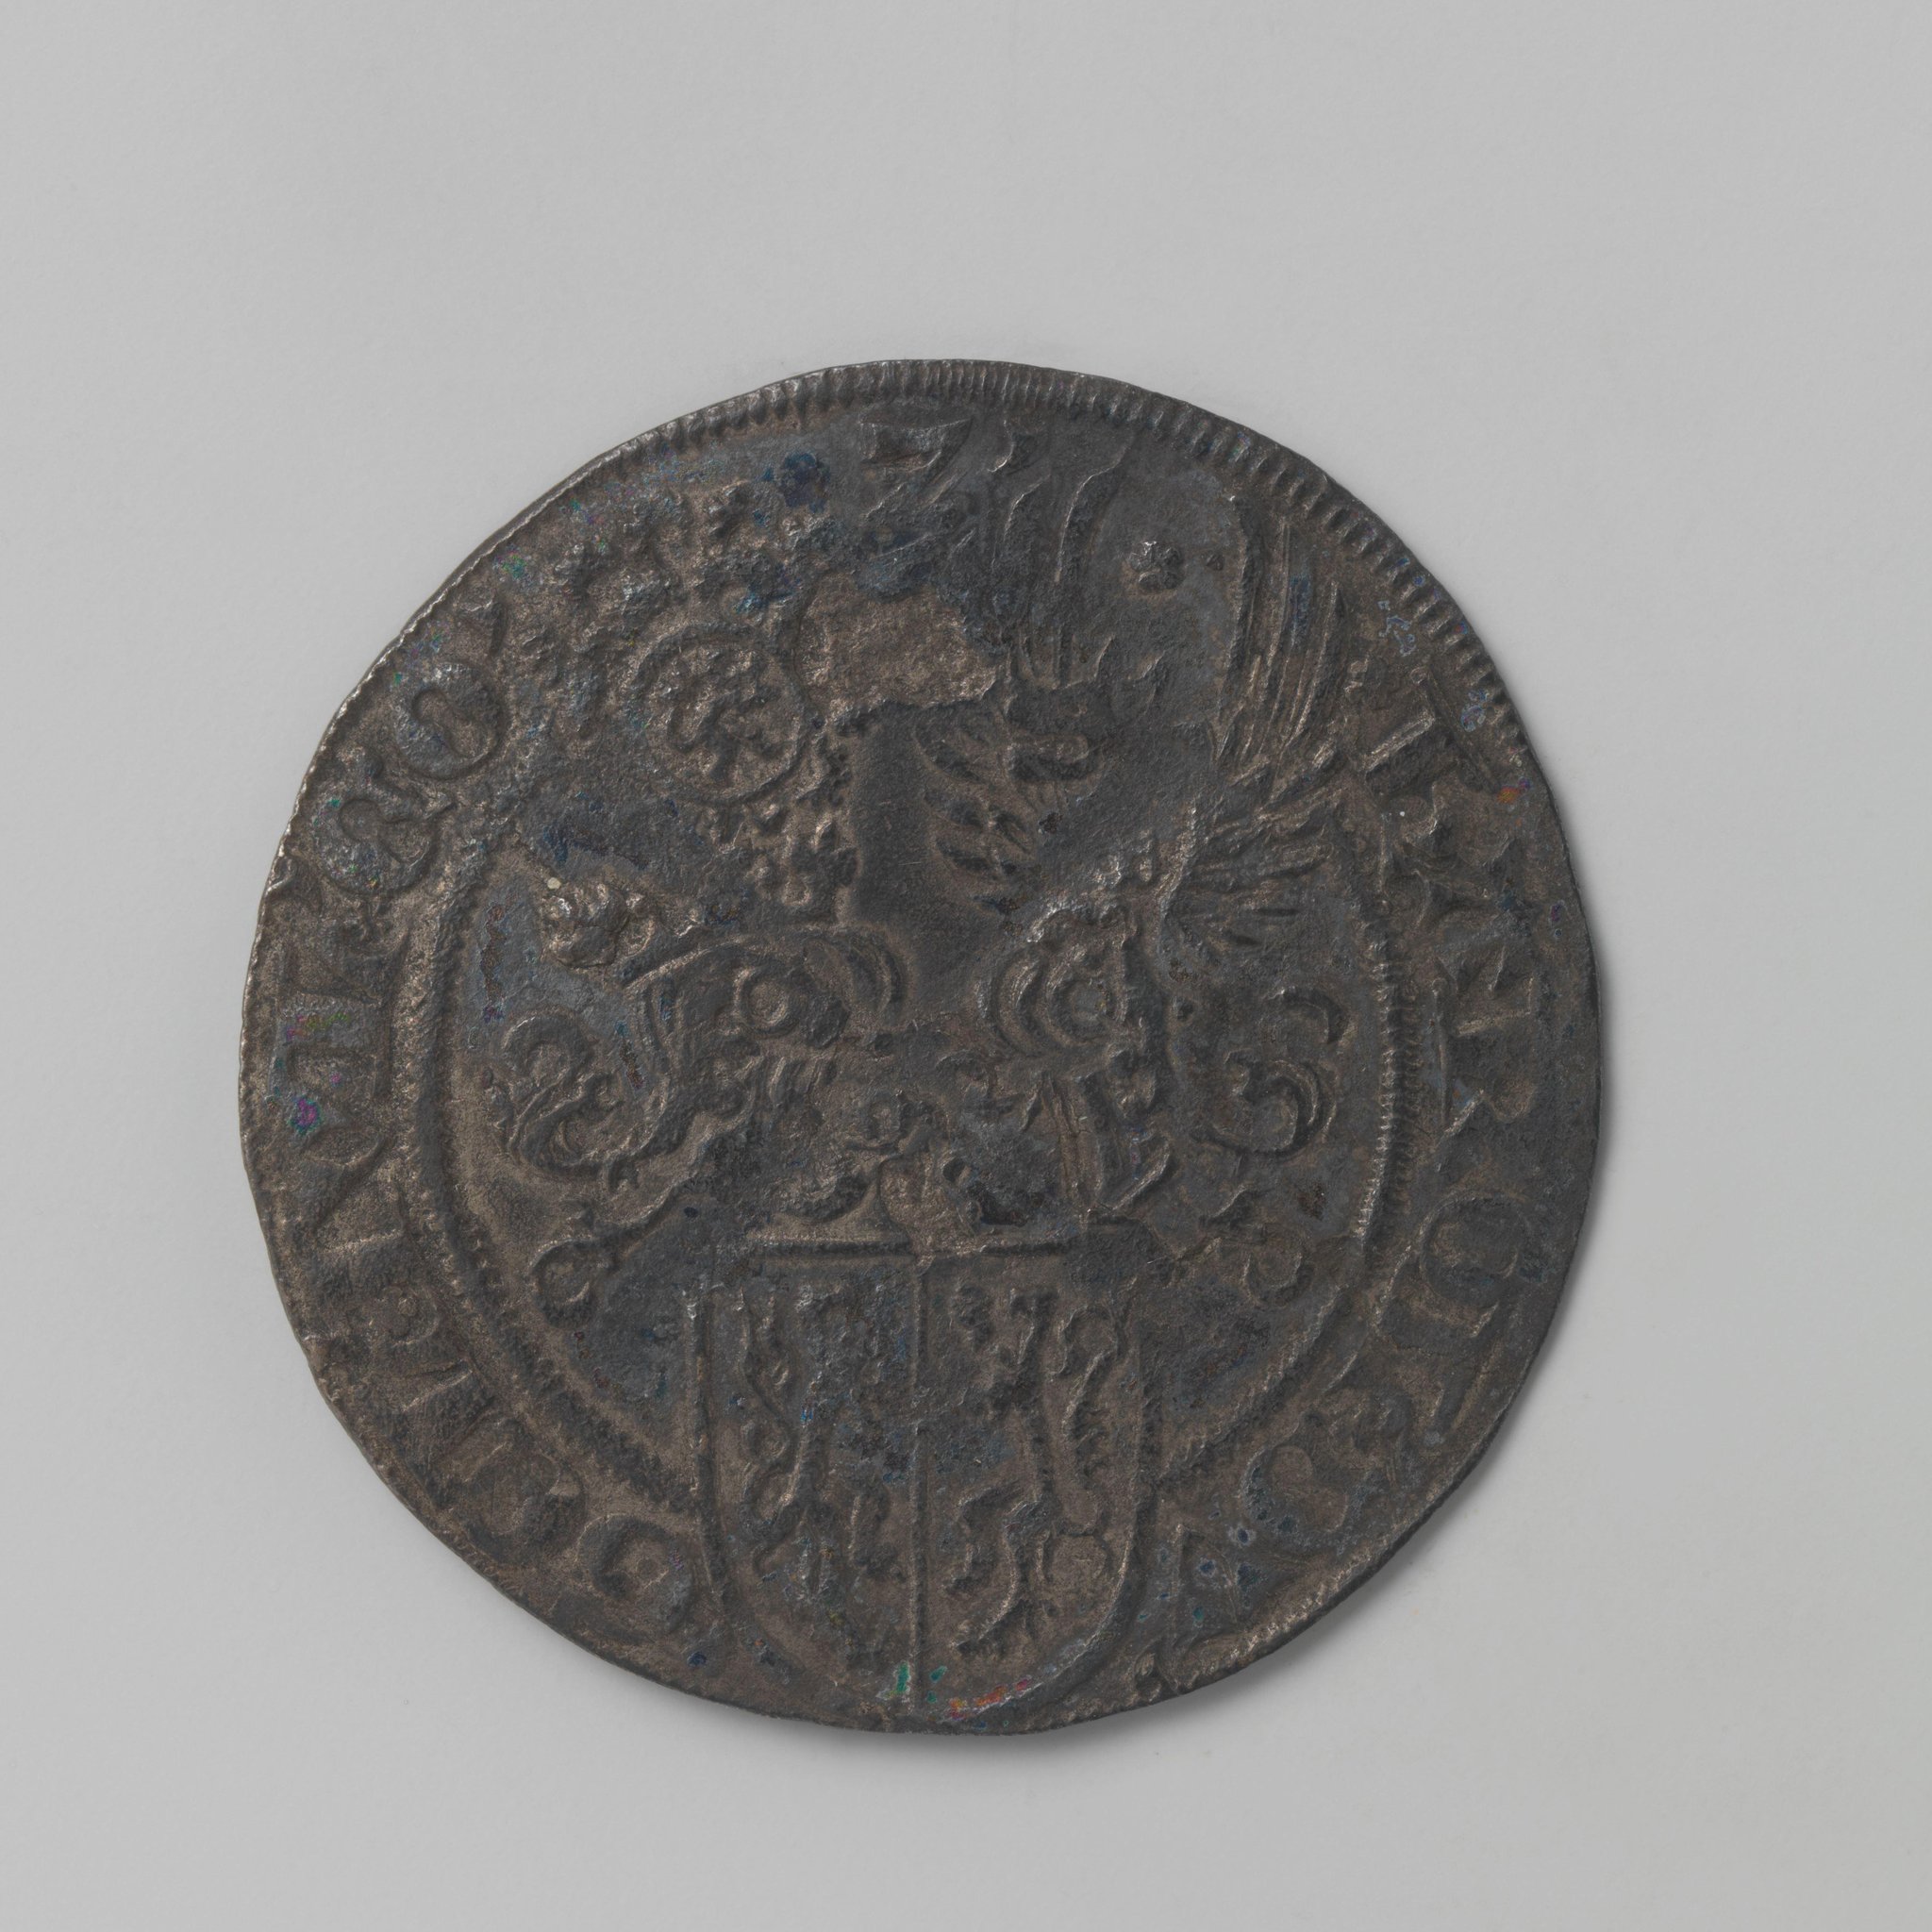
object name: coin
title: Gelderland, Karel van Egmond, dubbele stuiver, 1496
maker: karel van egmond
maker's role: earl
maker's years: 1467-1538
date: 1496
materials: silver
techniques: striking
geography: gelderland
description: Zilveren munt. Voorzijde: onder twee helmen met helmtekens Gelders wapenschild. Keerzijde: kort gevoet kruis, in hoeken afwisselend leeuw en lelie. In omschrift jaartal 96.